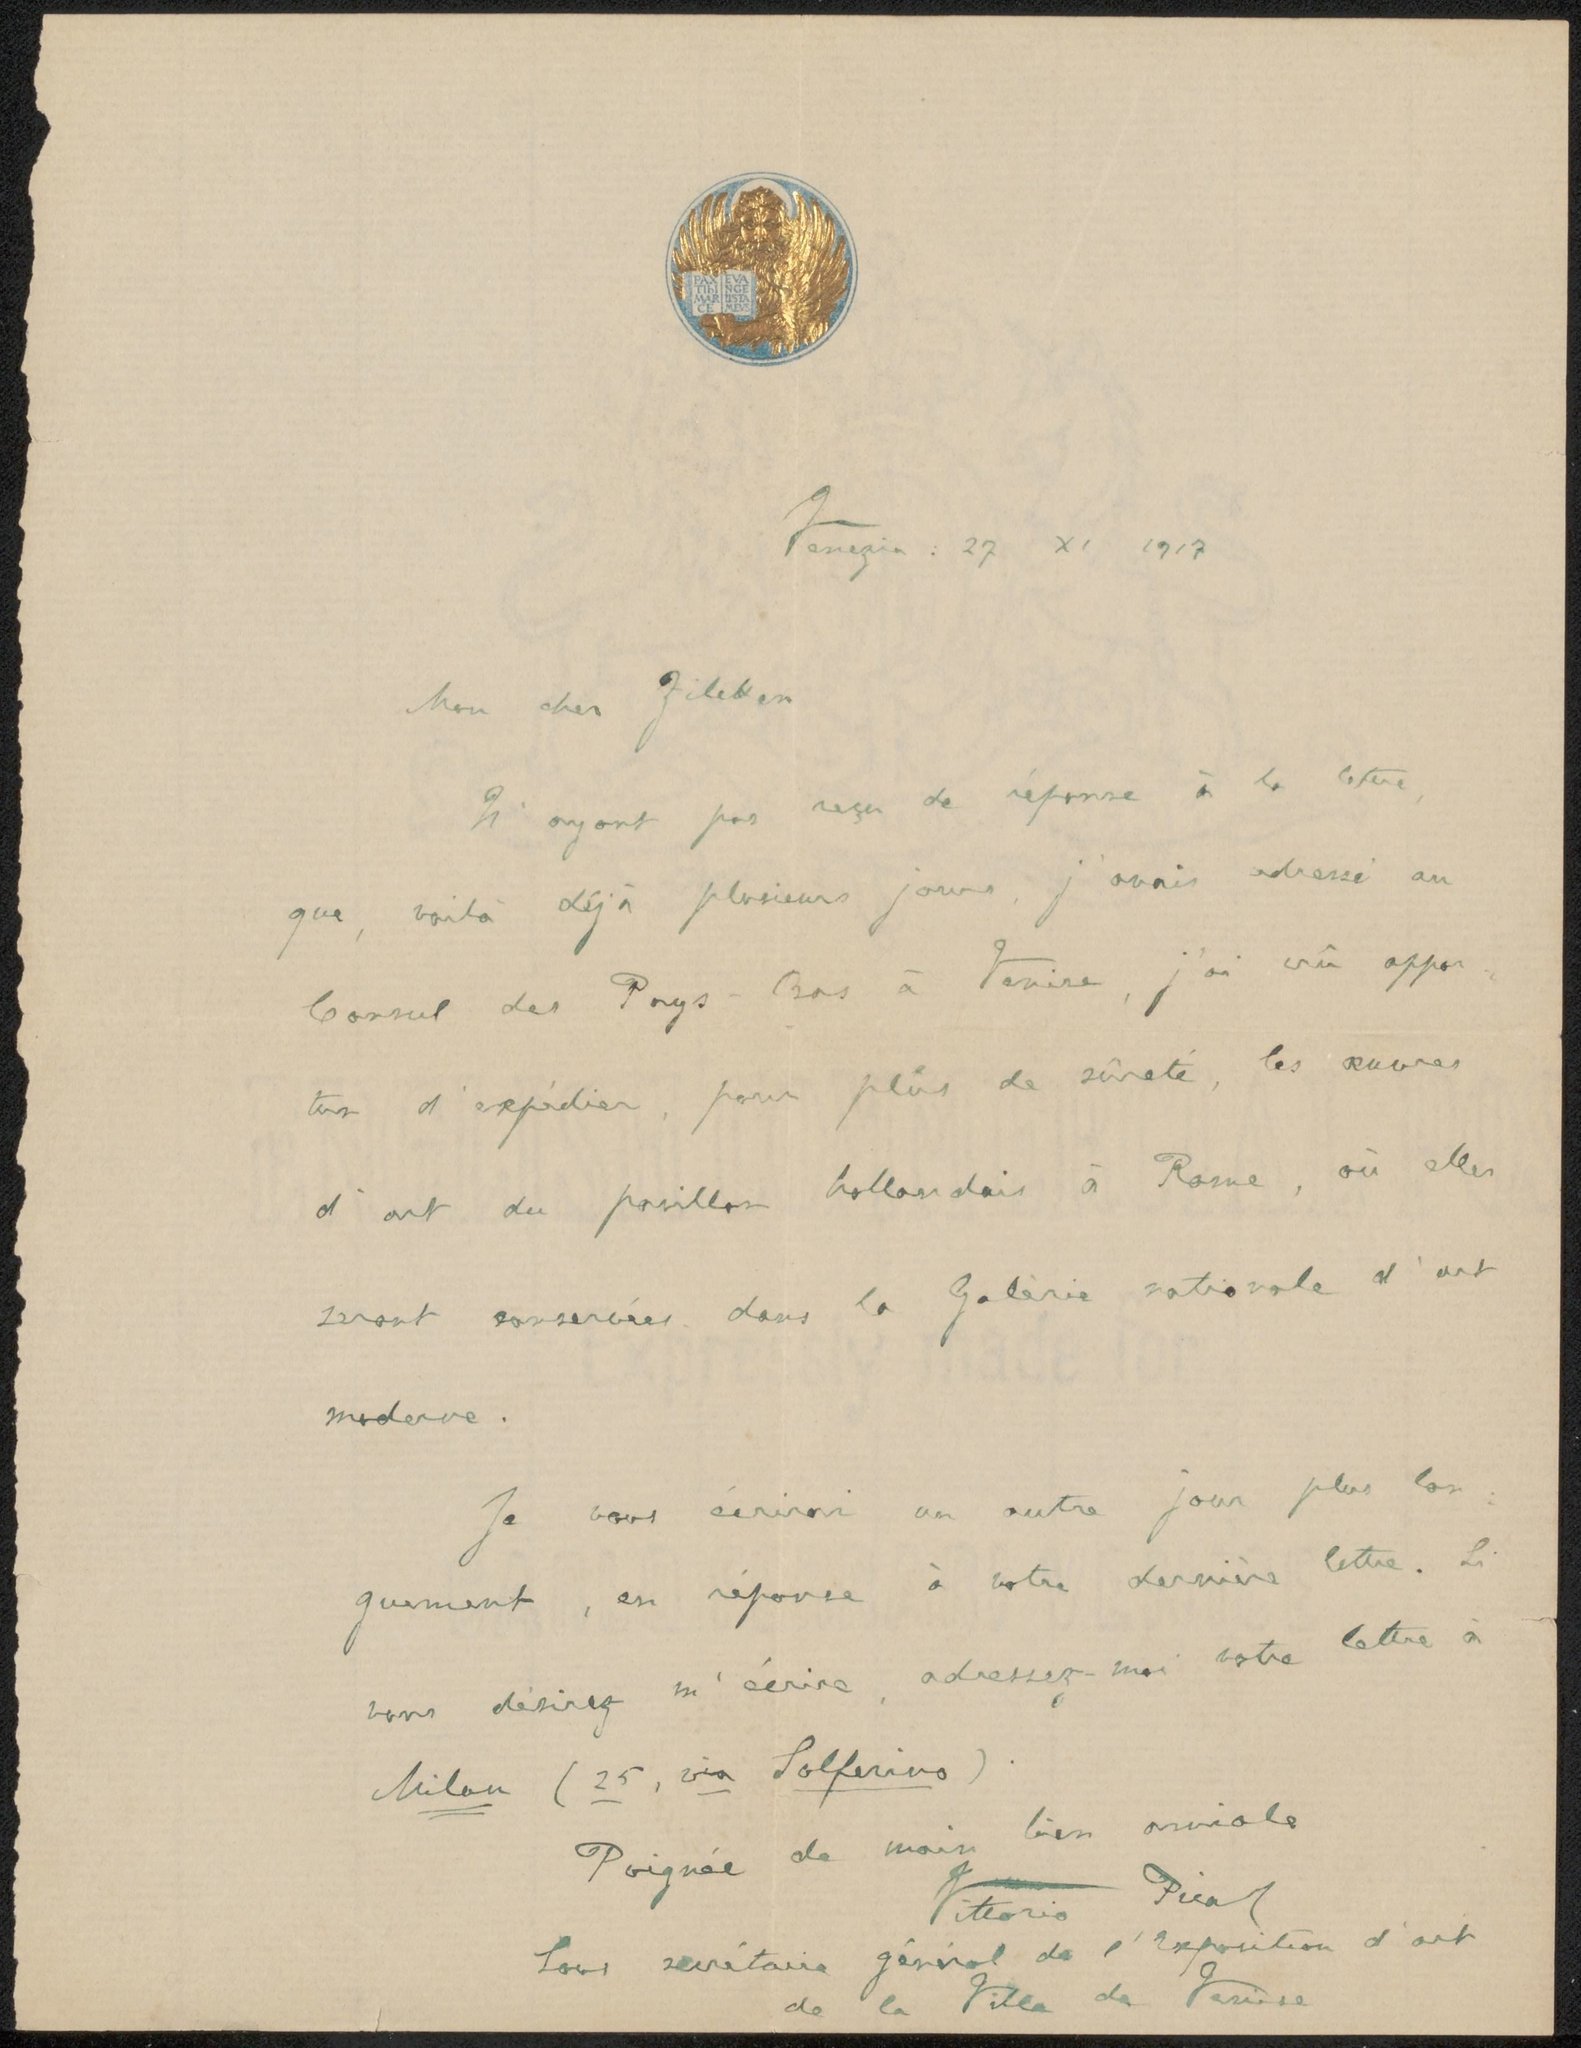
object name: letter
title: Brief aan Philip Zilcken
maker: vittorio pica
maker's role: criticus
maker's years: 1864-1930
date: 1917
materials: ink, paper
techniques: pen, printing, writing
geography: venice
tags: the hague, painter, draughtsman, philip zilcken, exhibition ~ art, venice, rome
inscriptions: seal, collector's mark: ‘RPK’, watermark